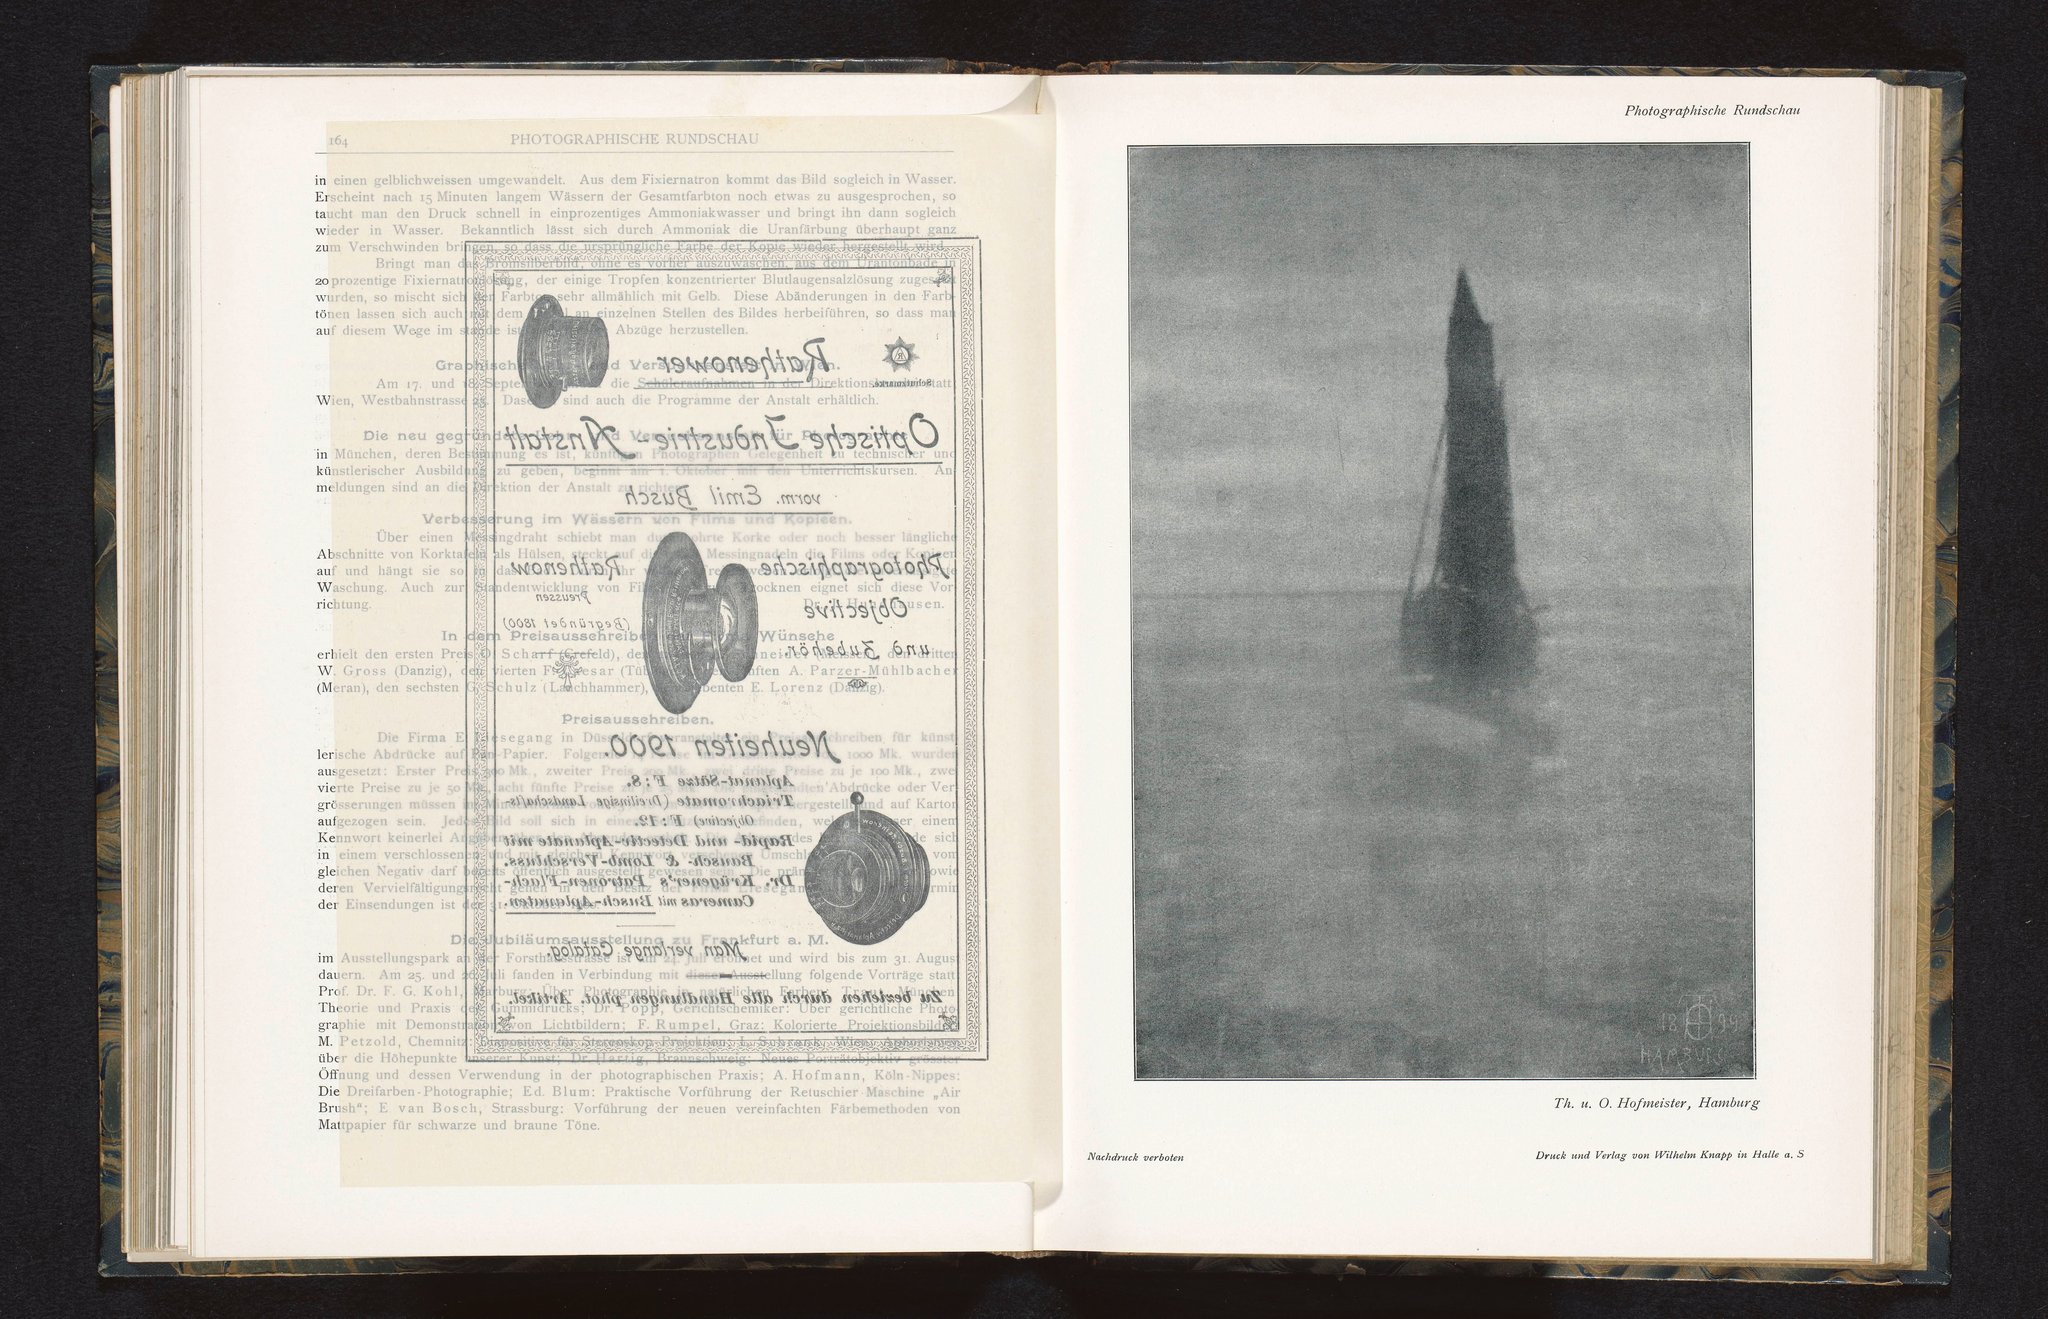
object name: photomechanical print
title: Gezicht op een zeilboot te water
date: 1895-1900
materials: paper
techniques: autotype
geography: halle an der saale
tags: sailing-ship, sailing-boat, landscapes with waters, waterscapes, seascapes (in the temperate zone)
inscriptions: inscription: ‘1899/ Hamburg’, inscription: ‘Nachdruck verboten’